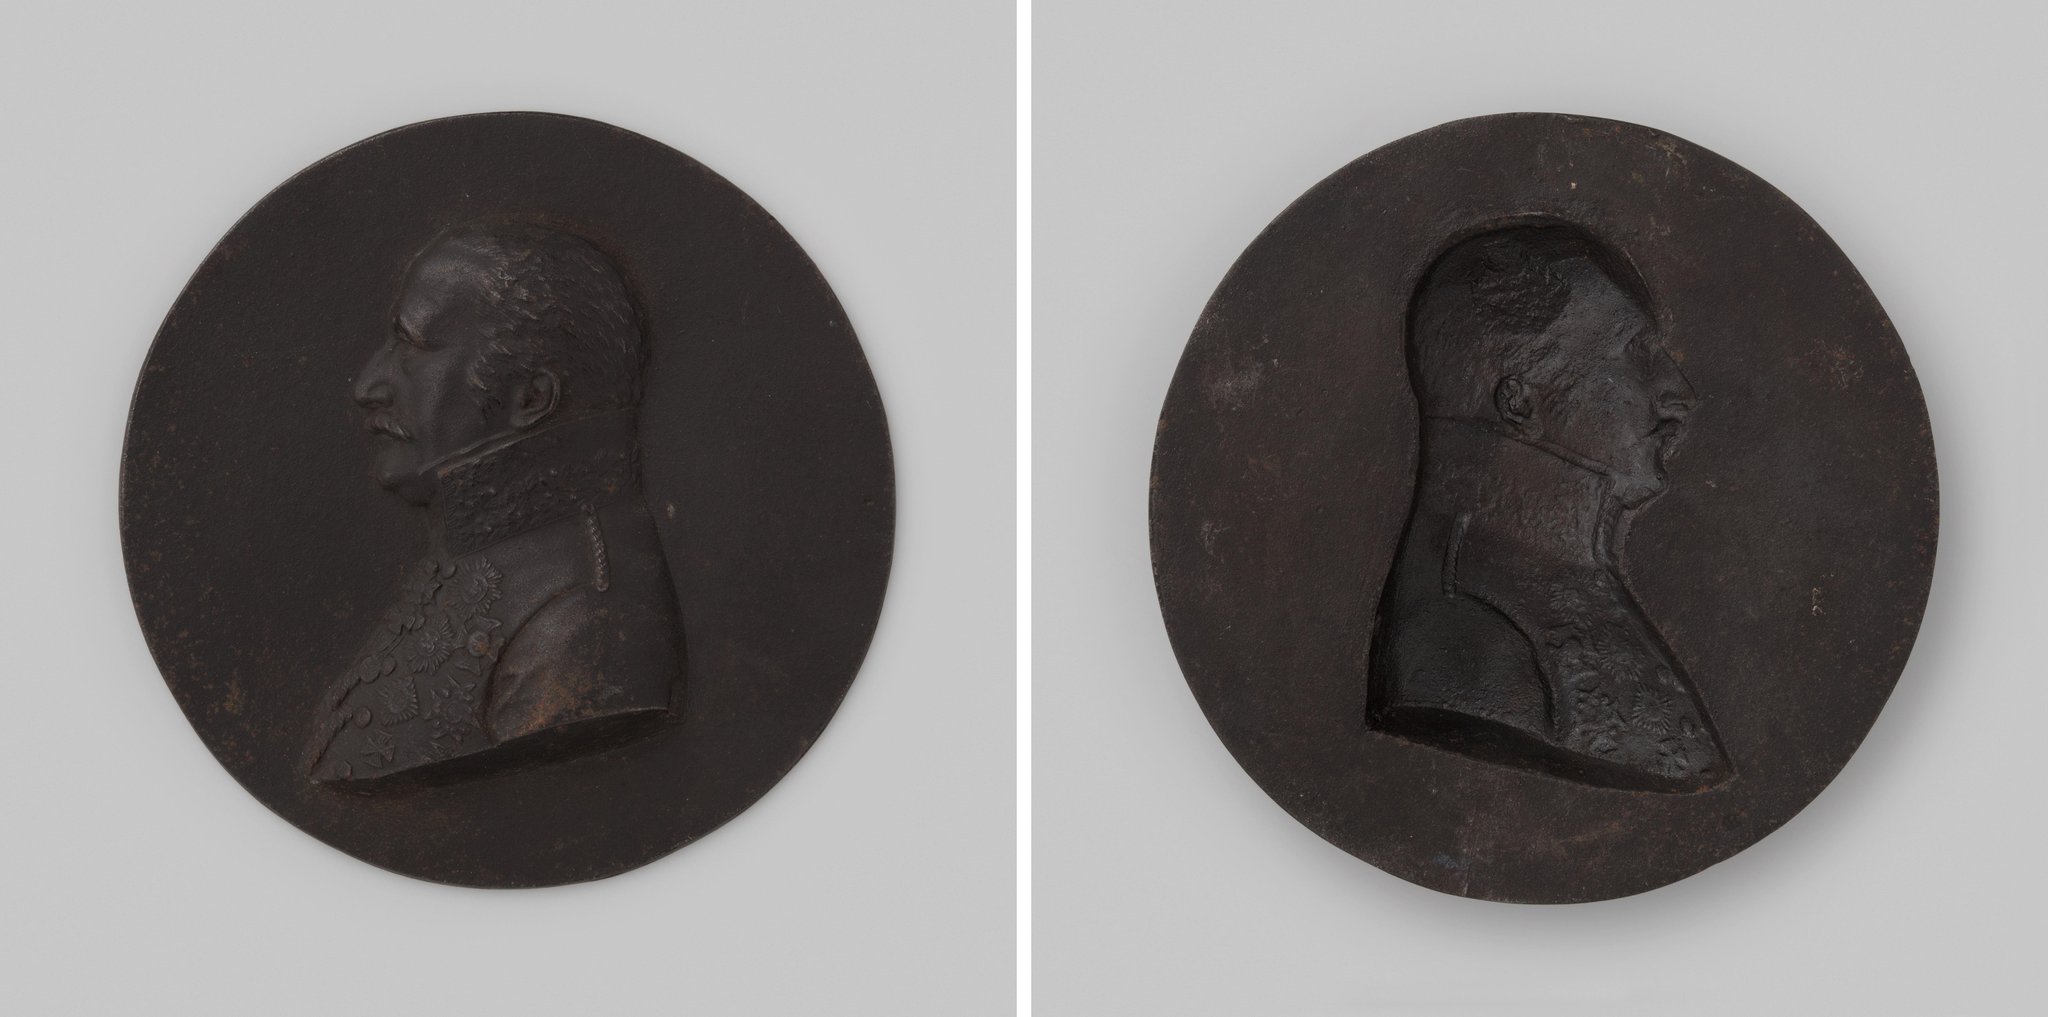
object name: plaque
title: Portret van een man van de Duitse Koninklijke familie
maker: leonhard posch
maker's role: sculptor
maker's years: 1750-1831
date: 1825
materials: iron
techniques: casting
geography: berlin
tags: berlin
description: IJzeren penning. Voorzijde: borststuk man.